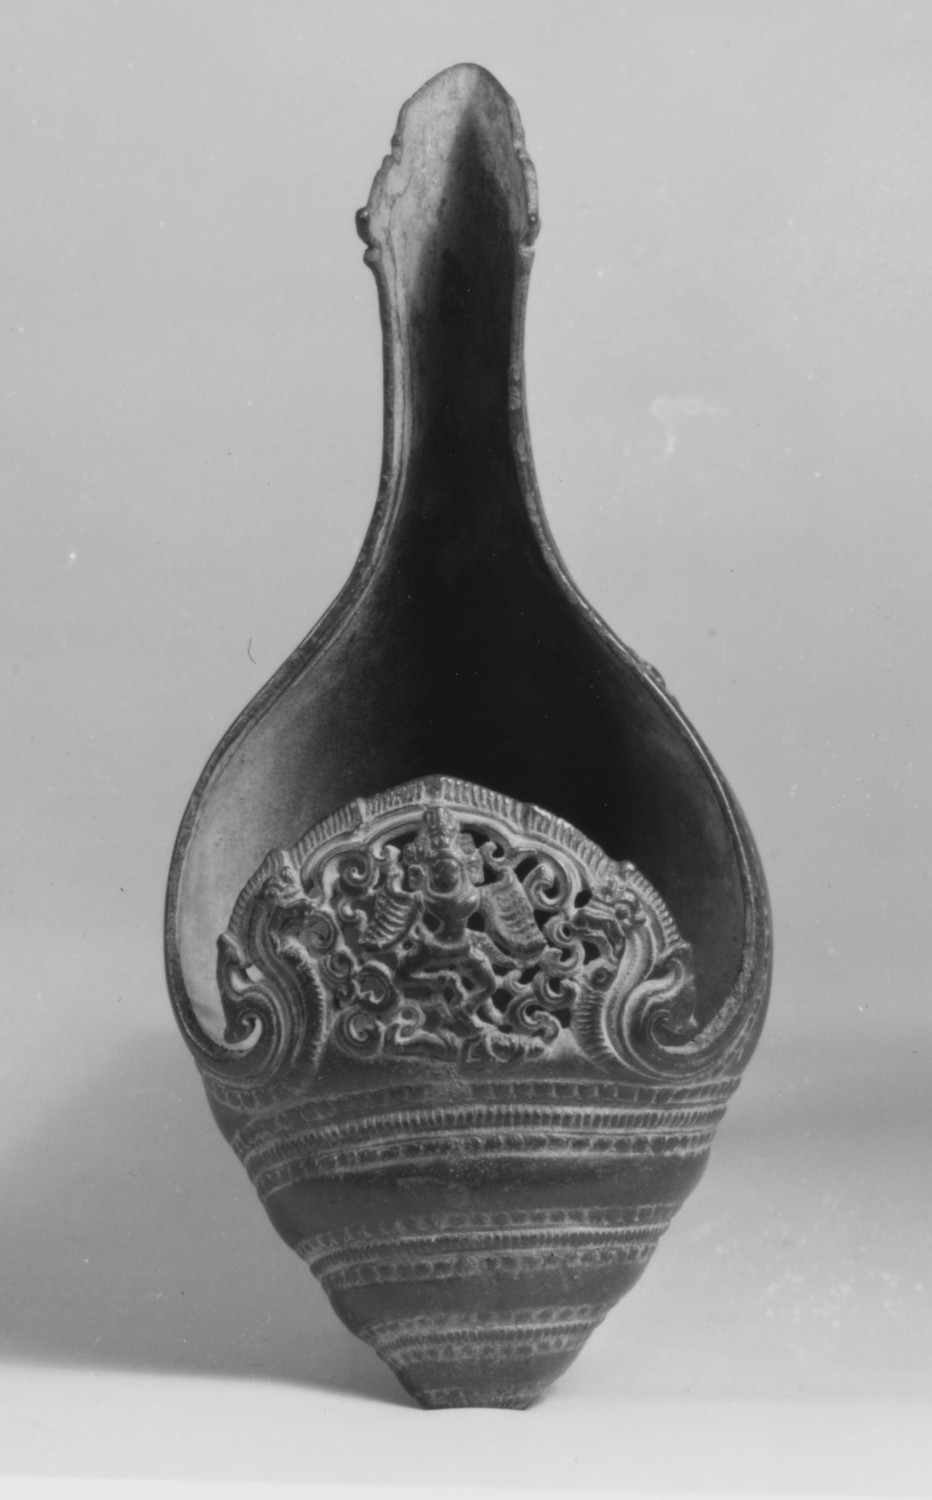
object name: libation vessel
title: Libation Vessel in the Form of a Conch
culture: cambodian or thai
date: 1101-1200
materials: bronze